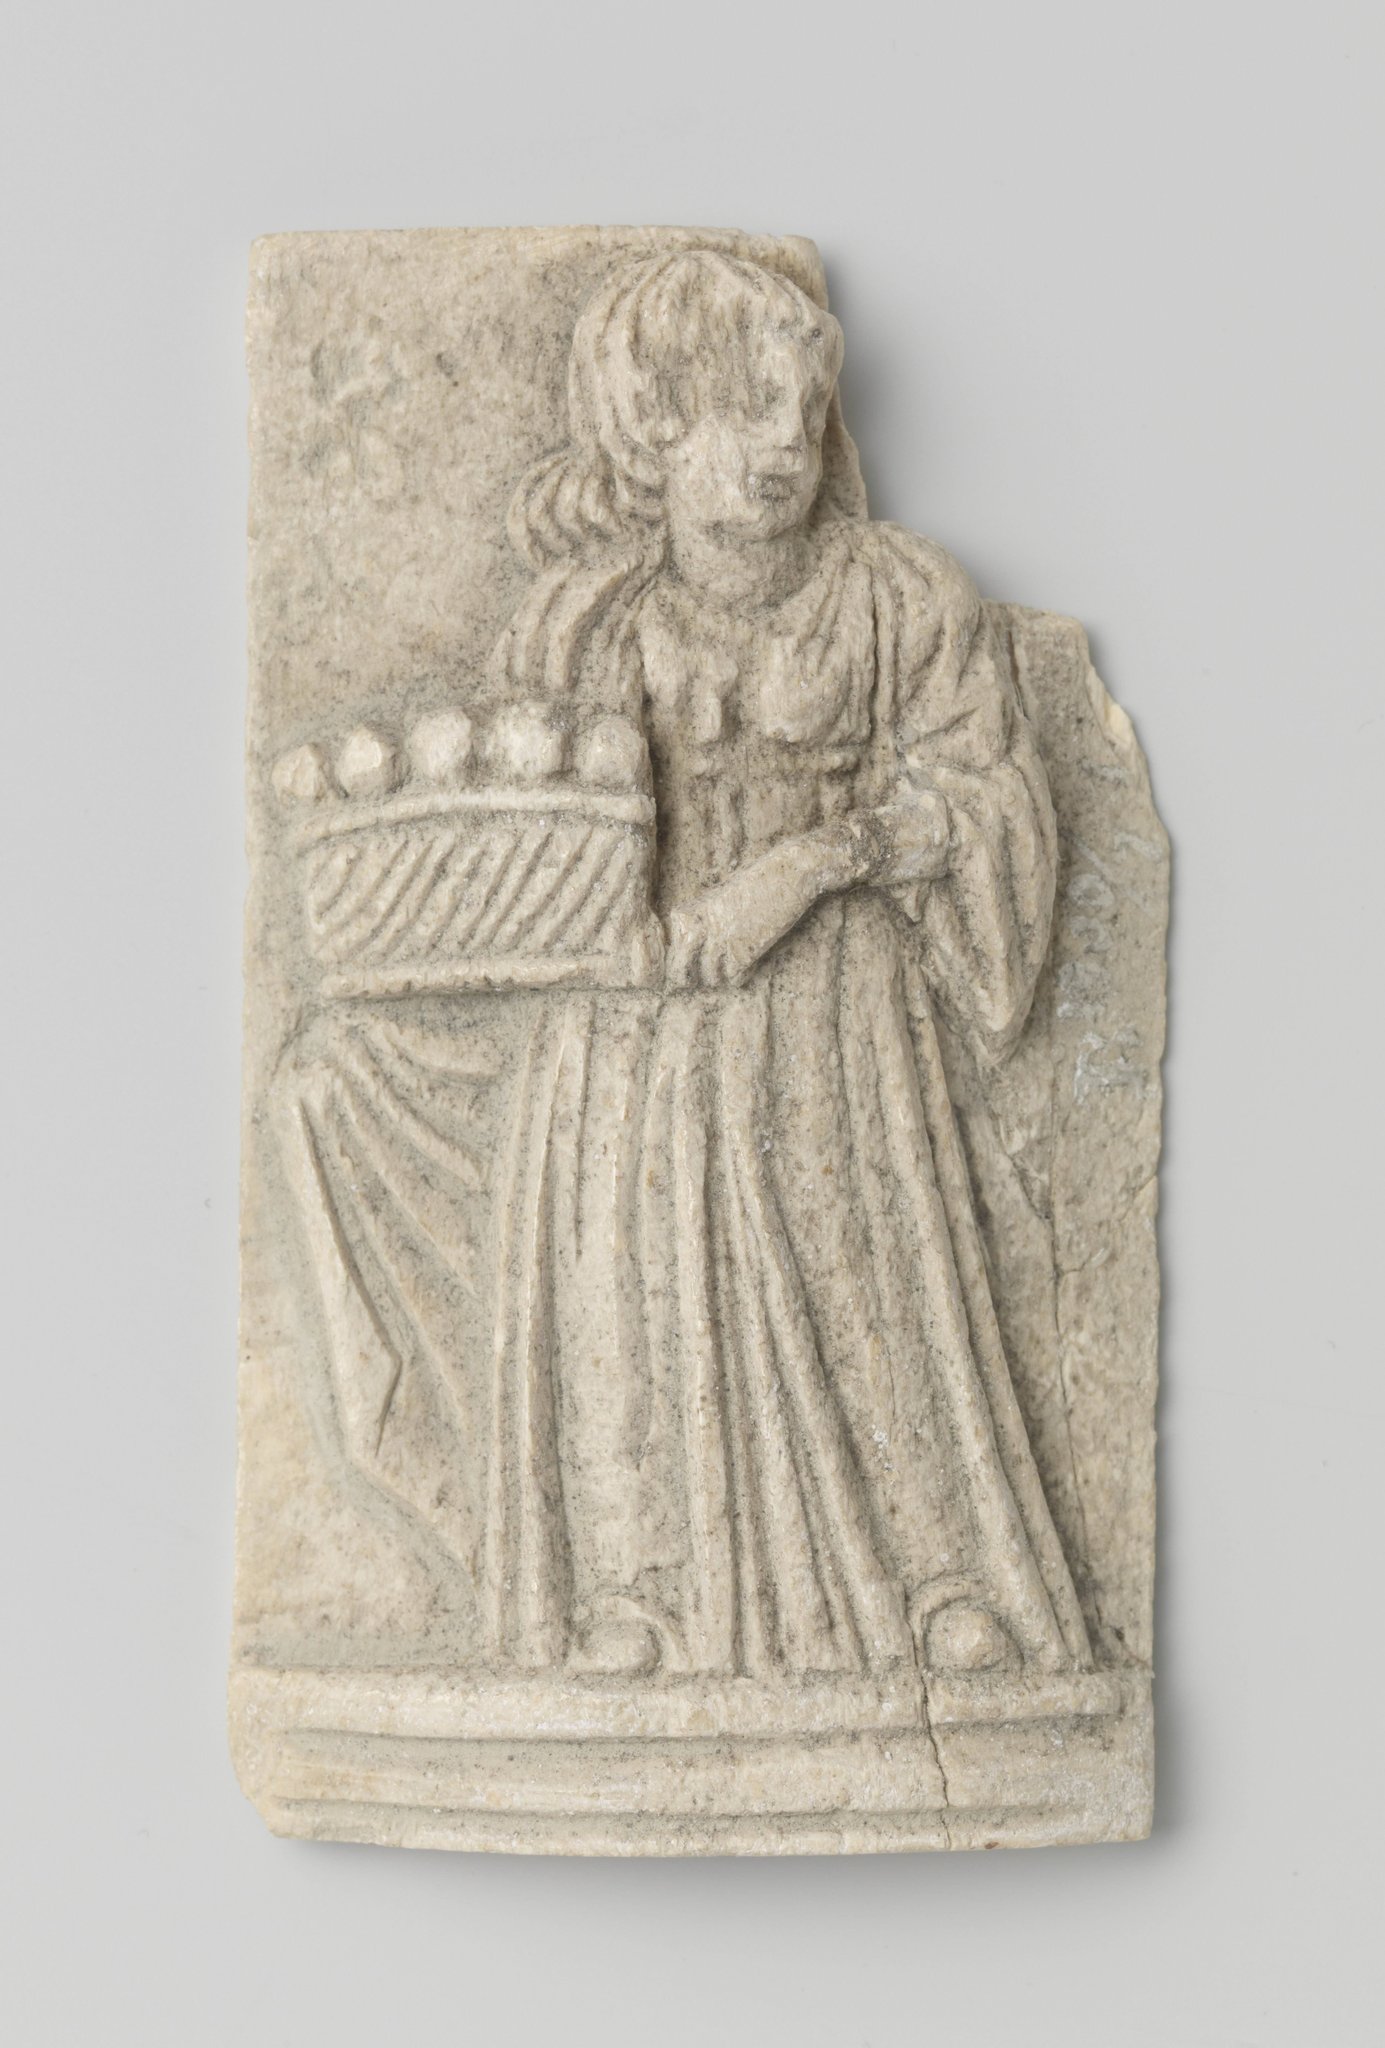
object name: sculpture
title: Voortschrijdende vrouw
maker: baldassare degli embriachi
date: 1400-1425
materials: bone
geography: venice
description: Langwerpig reliëf met voortschrijdende vrouw in lang gewaad, in beide handen een mand met vruchten dragend.